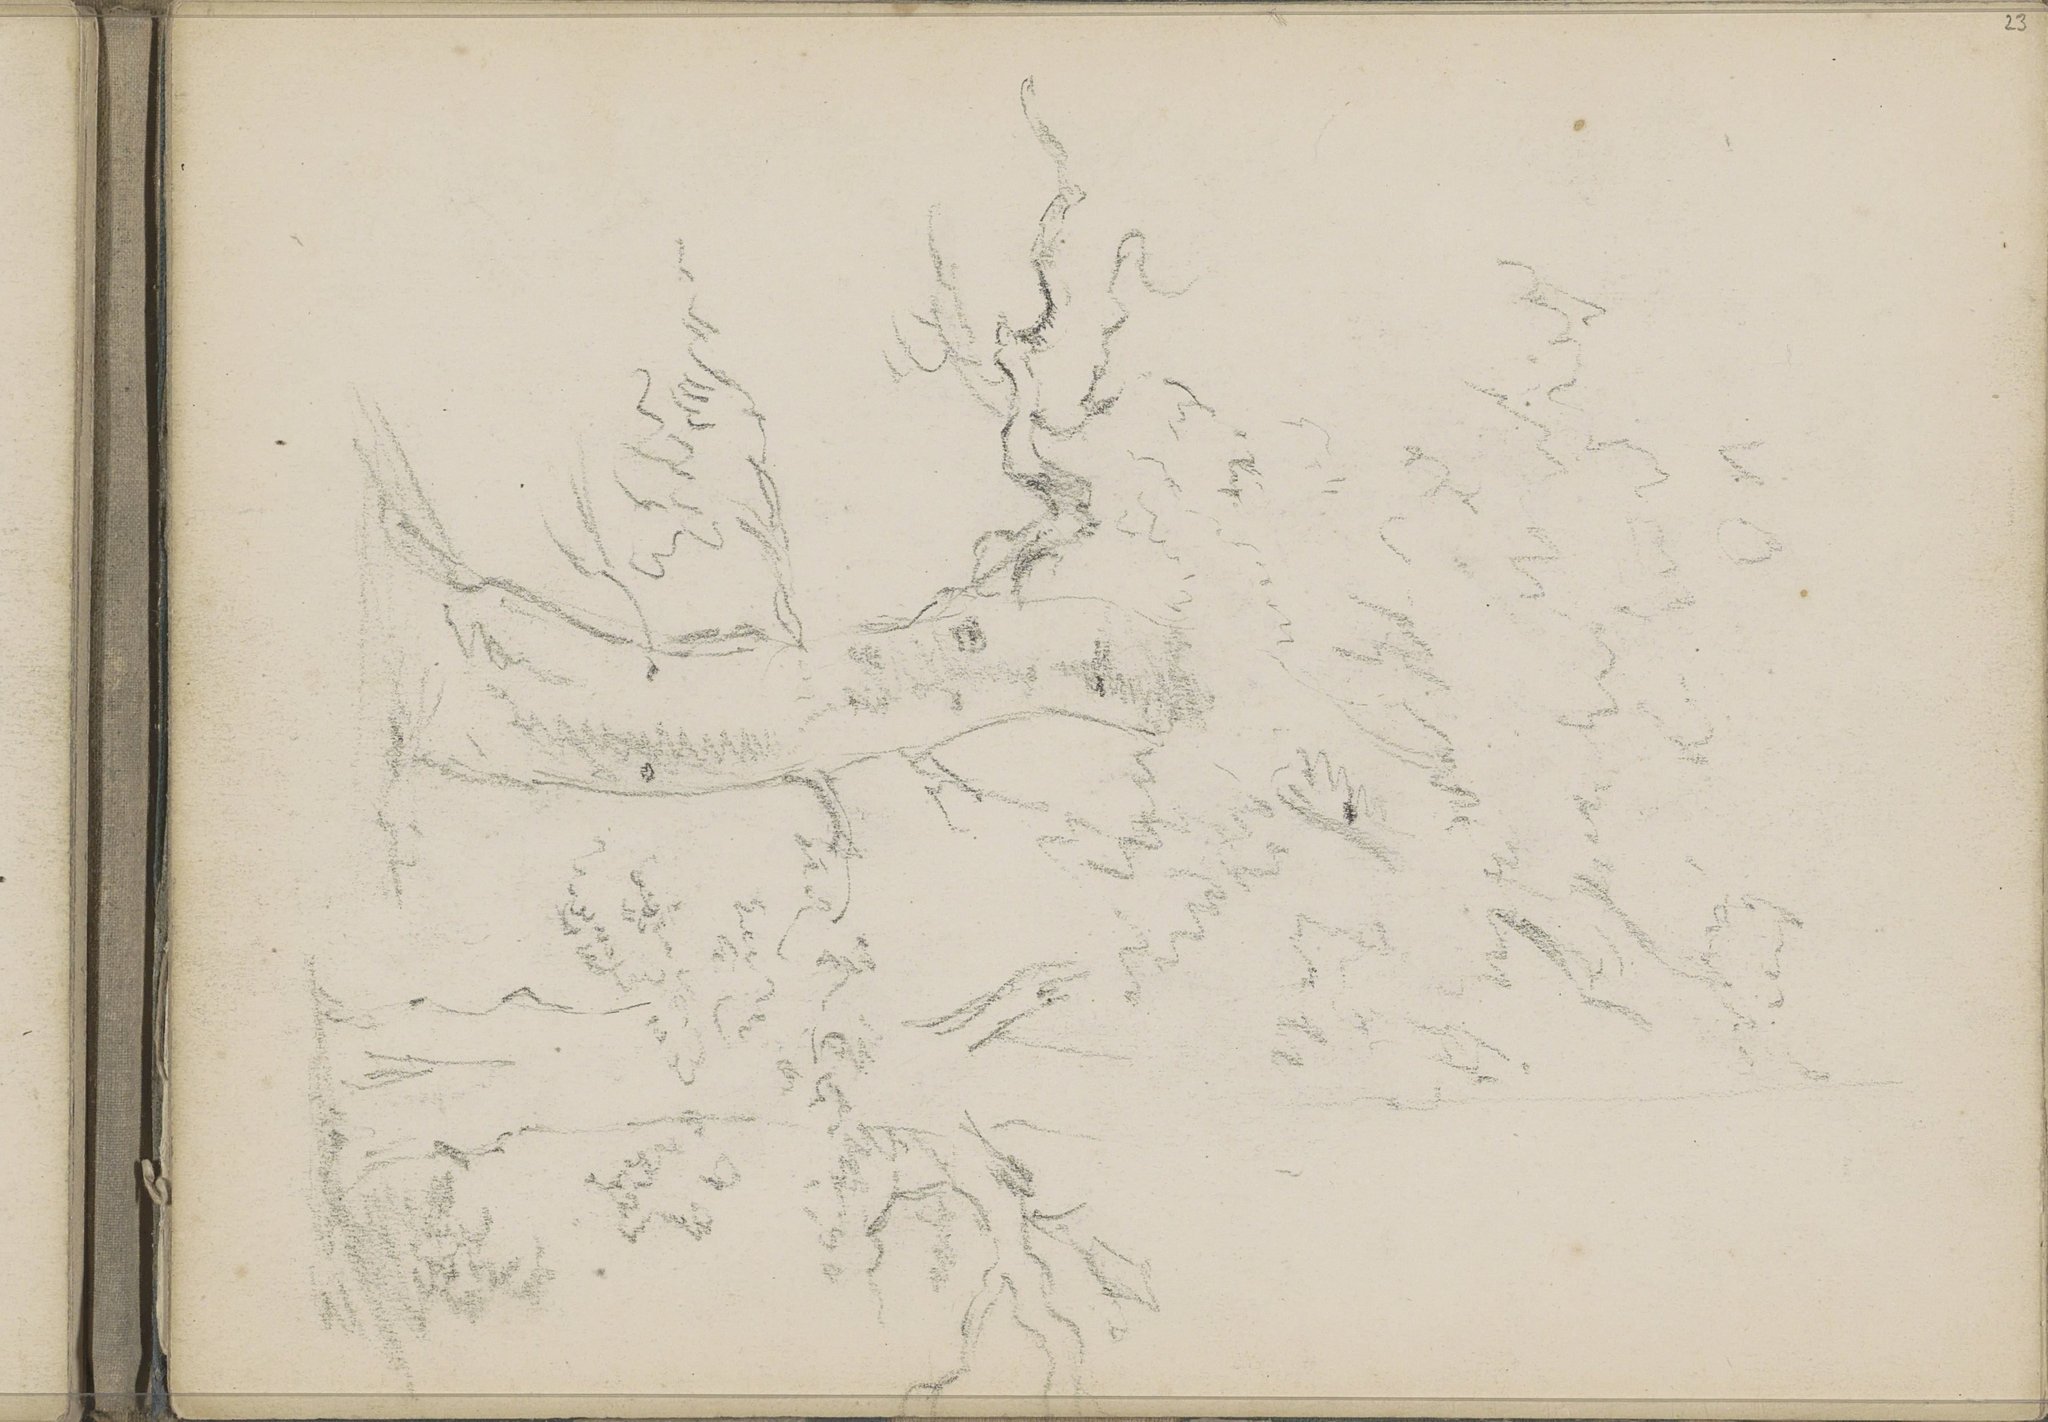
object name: sketchbook leaf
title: Bomen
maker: willem cornelis rip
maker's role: draughtsman, painter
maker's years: 1856-1922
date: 1874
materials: paper, pencil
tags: trees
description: Blad 23 recto uit een schetsboek met 27 losse bladen.